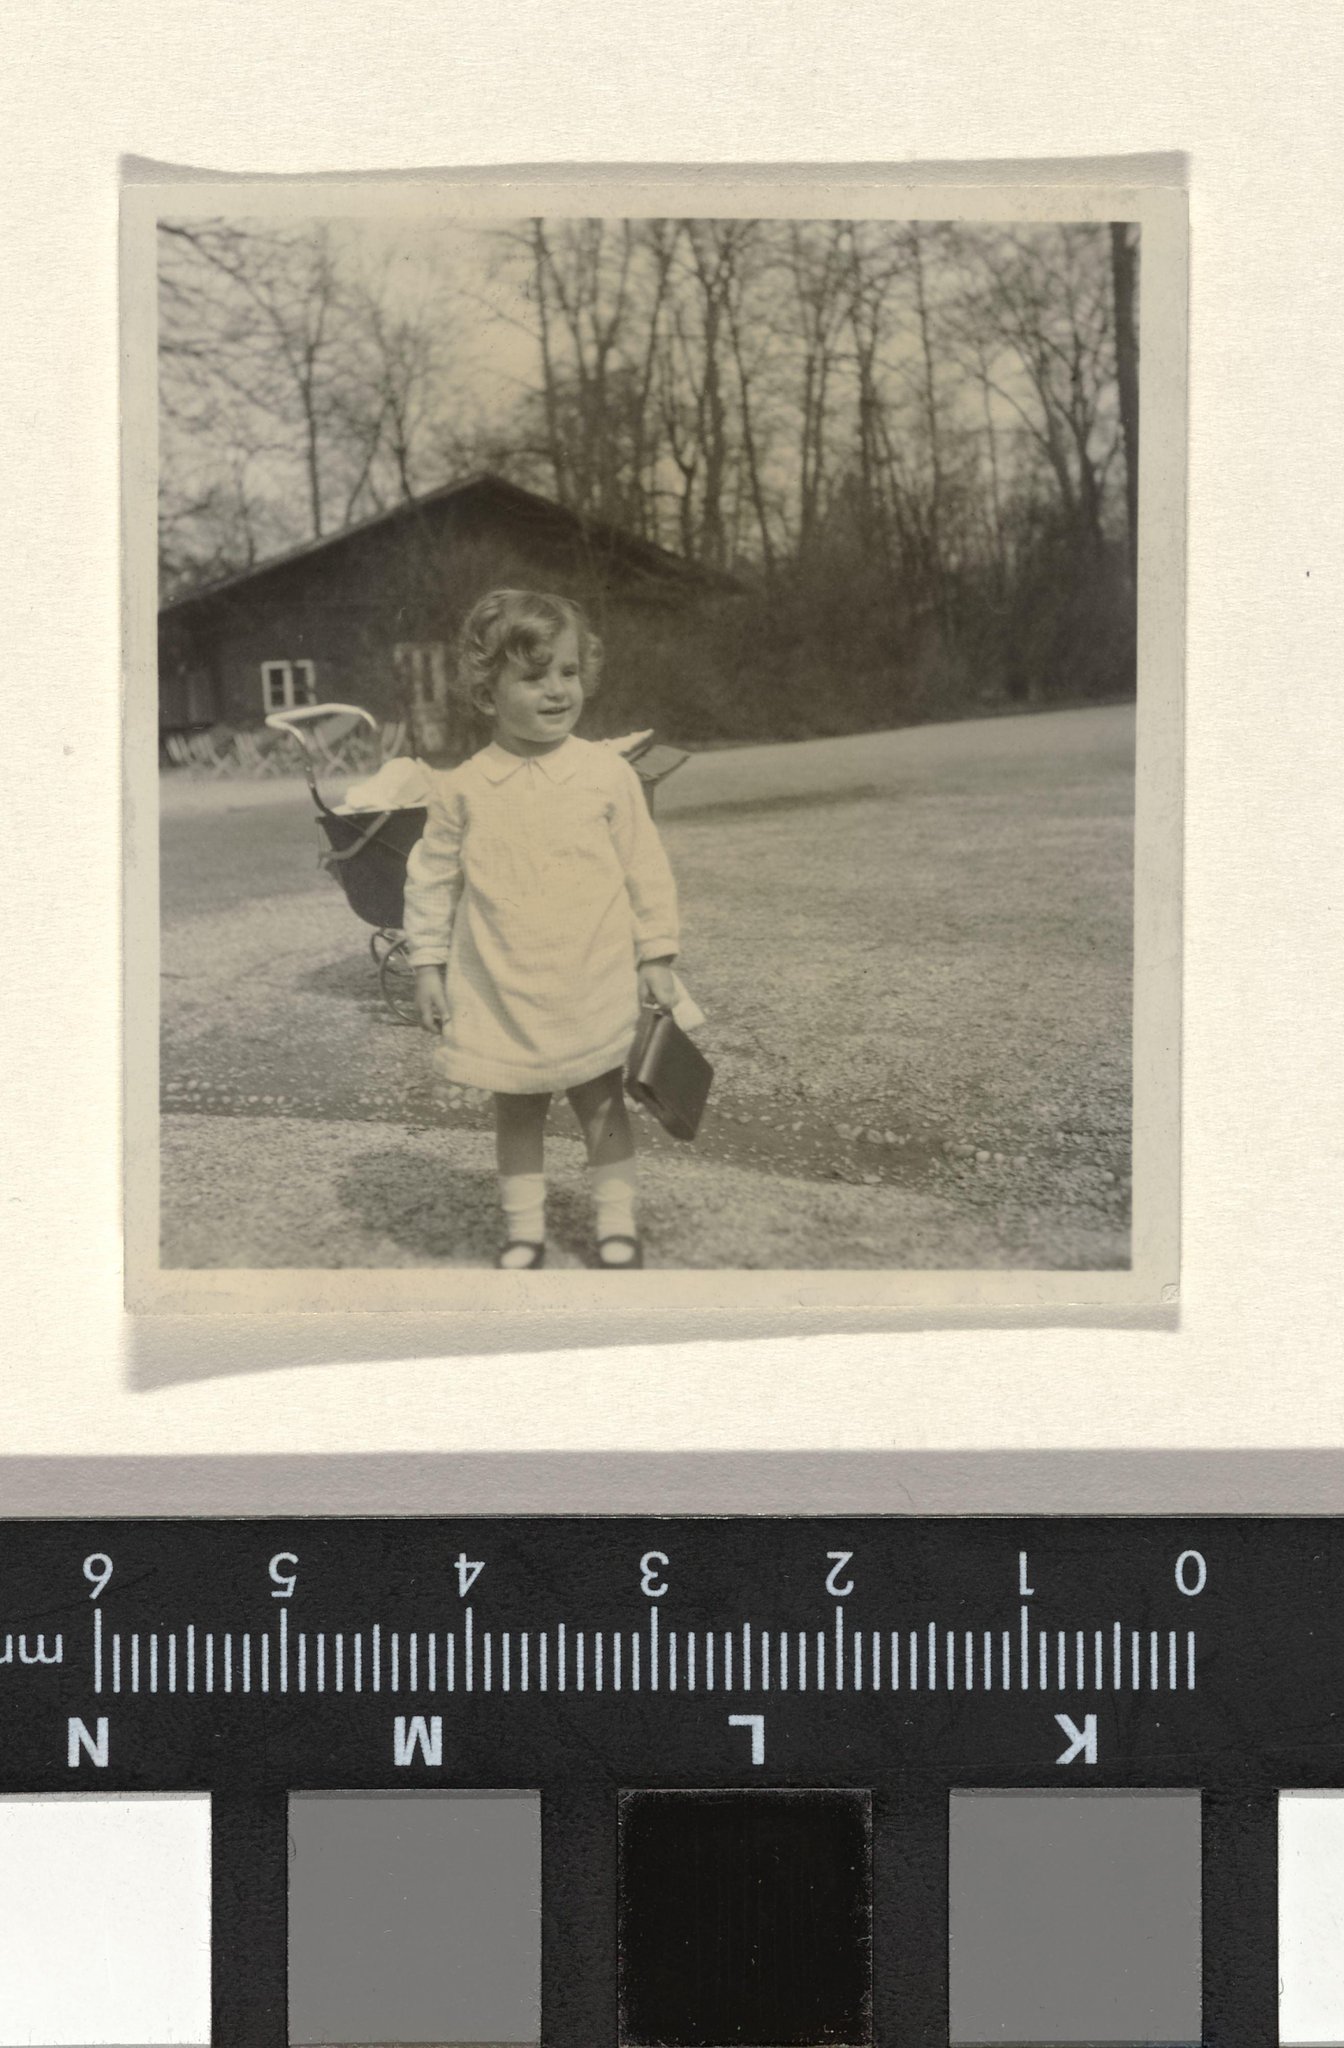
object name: photograph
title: Isabel Wachenheimer in de Engelse Tuinen in München, september 1930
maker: Anonymous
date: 1909-1930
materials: photographic support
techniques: gelatin silver print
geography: munich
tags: leiden, isabel wachenheimer-elon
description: Dit object is onderdeel van de nalatenschap van Isabel Elon-Wachenheimer (1928-2010). Tot haar overlijden behoorde het samen met de andere objecten uit de nalatenschap tot haar privédomein van Isabel Wachenheimer. In die particuliere context zijn deze objecten tezamen en individueel aandenkens - aan de jeugd, ouders en familie van Isabel Wachenheimer vóór en tijdens de Shoah en aan haar leven na de Tweede Wereldoorlog. Isabel Wachenheimer, die van juni 1943 tot mei 1945 gevangen zat in Kamp Westerbork, Theresienstadt, Auschwitz, Lenzing a/d Oberdonau (een buitenkamp van Mauthausen), overleefde de Shoah. Haar ouders – Eugène Wachenheimer en Else Wachenheimer-Moos - werden op 14 oktober 1944 in Auschwitz-Birkenau vermoord.